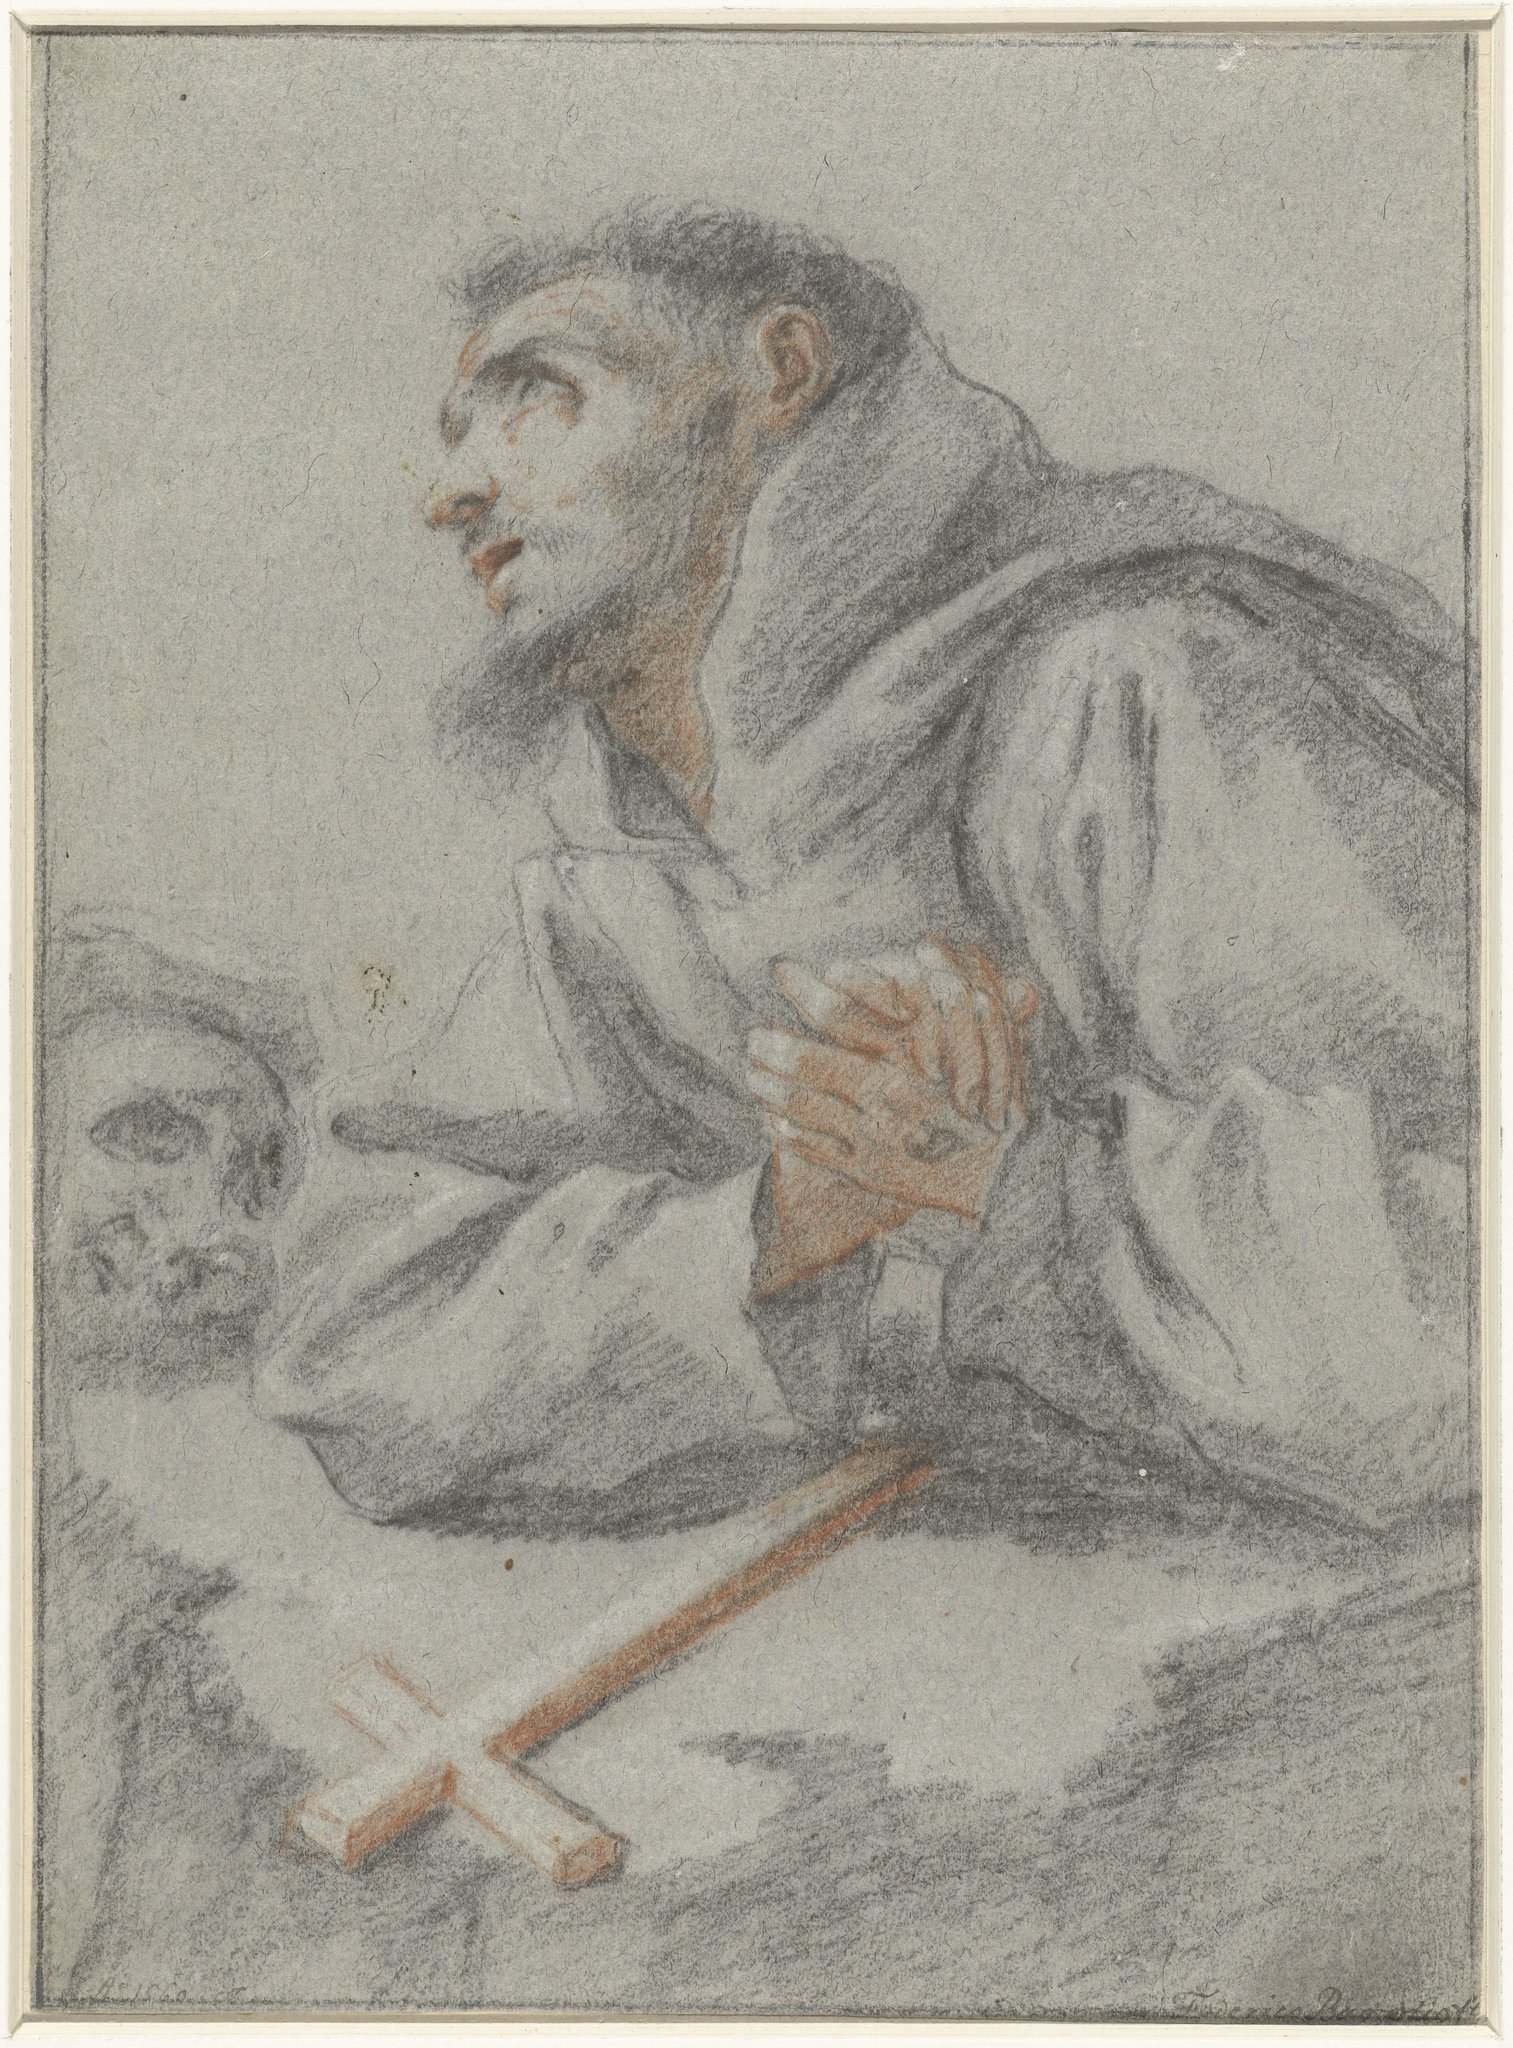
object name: drawing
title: Heilige Franciscus van Assisi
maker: lionello spada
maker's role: draughtsman, painter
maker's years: 1576-1622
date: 1586-1622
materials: chalk, paper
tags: founder of the order of friars minor (franciscans), francis(cus) of assisi; possible attributes: book, crucifix, lily, skull, stigmata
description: Heilige Franciscus van Assisi, biddend vóór een crucifix; links ligt een doodshoofd.